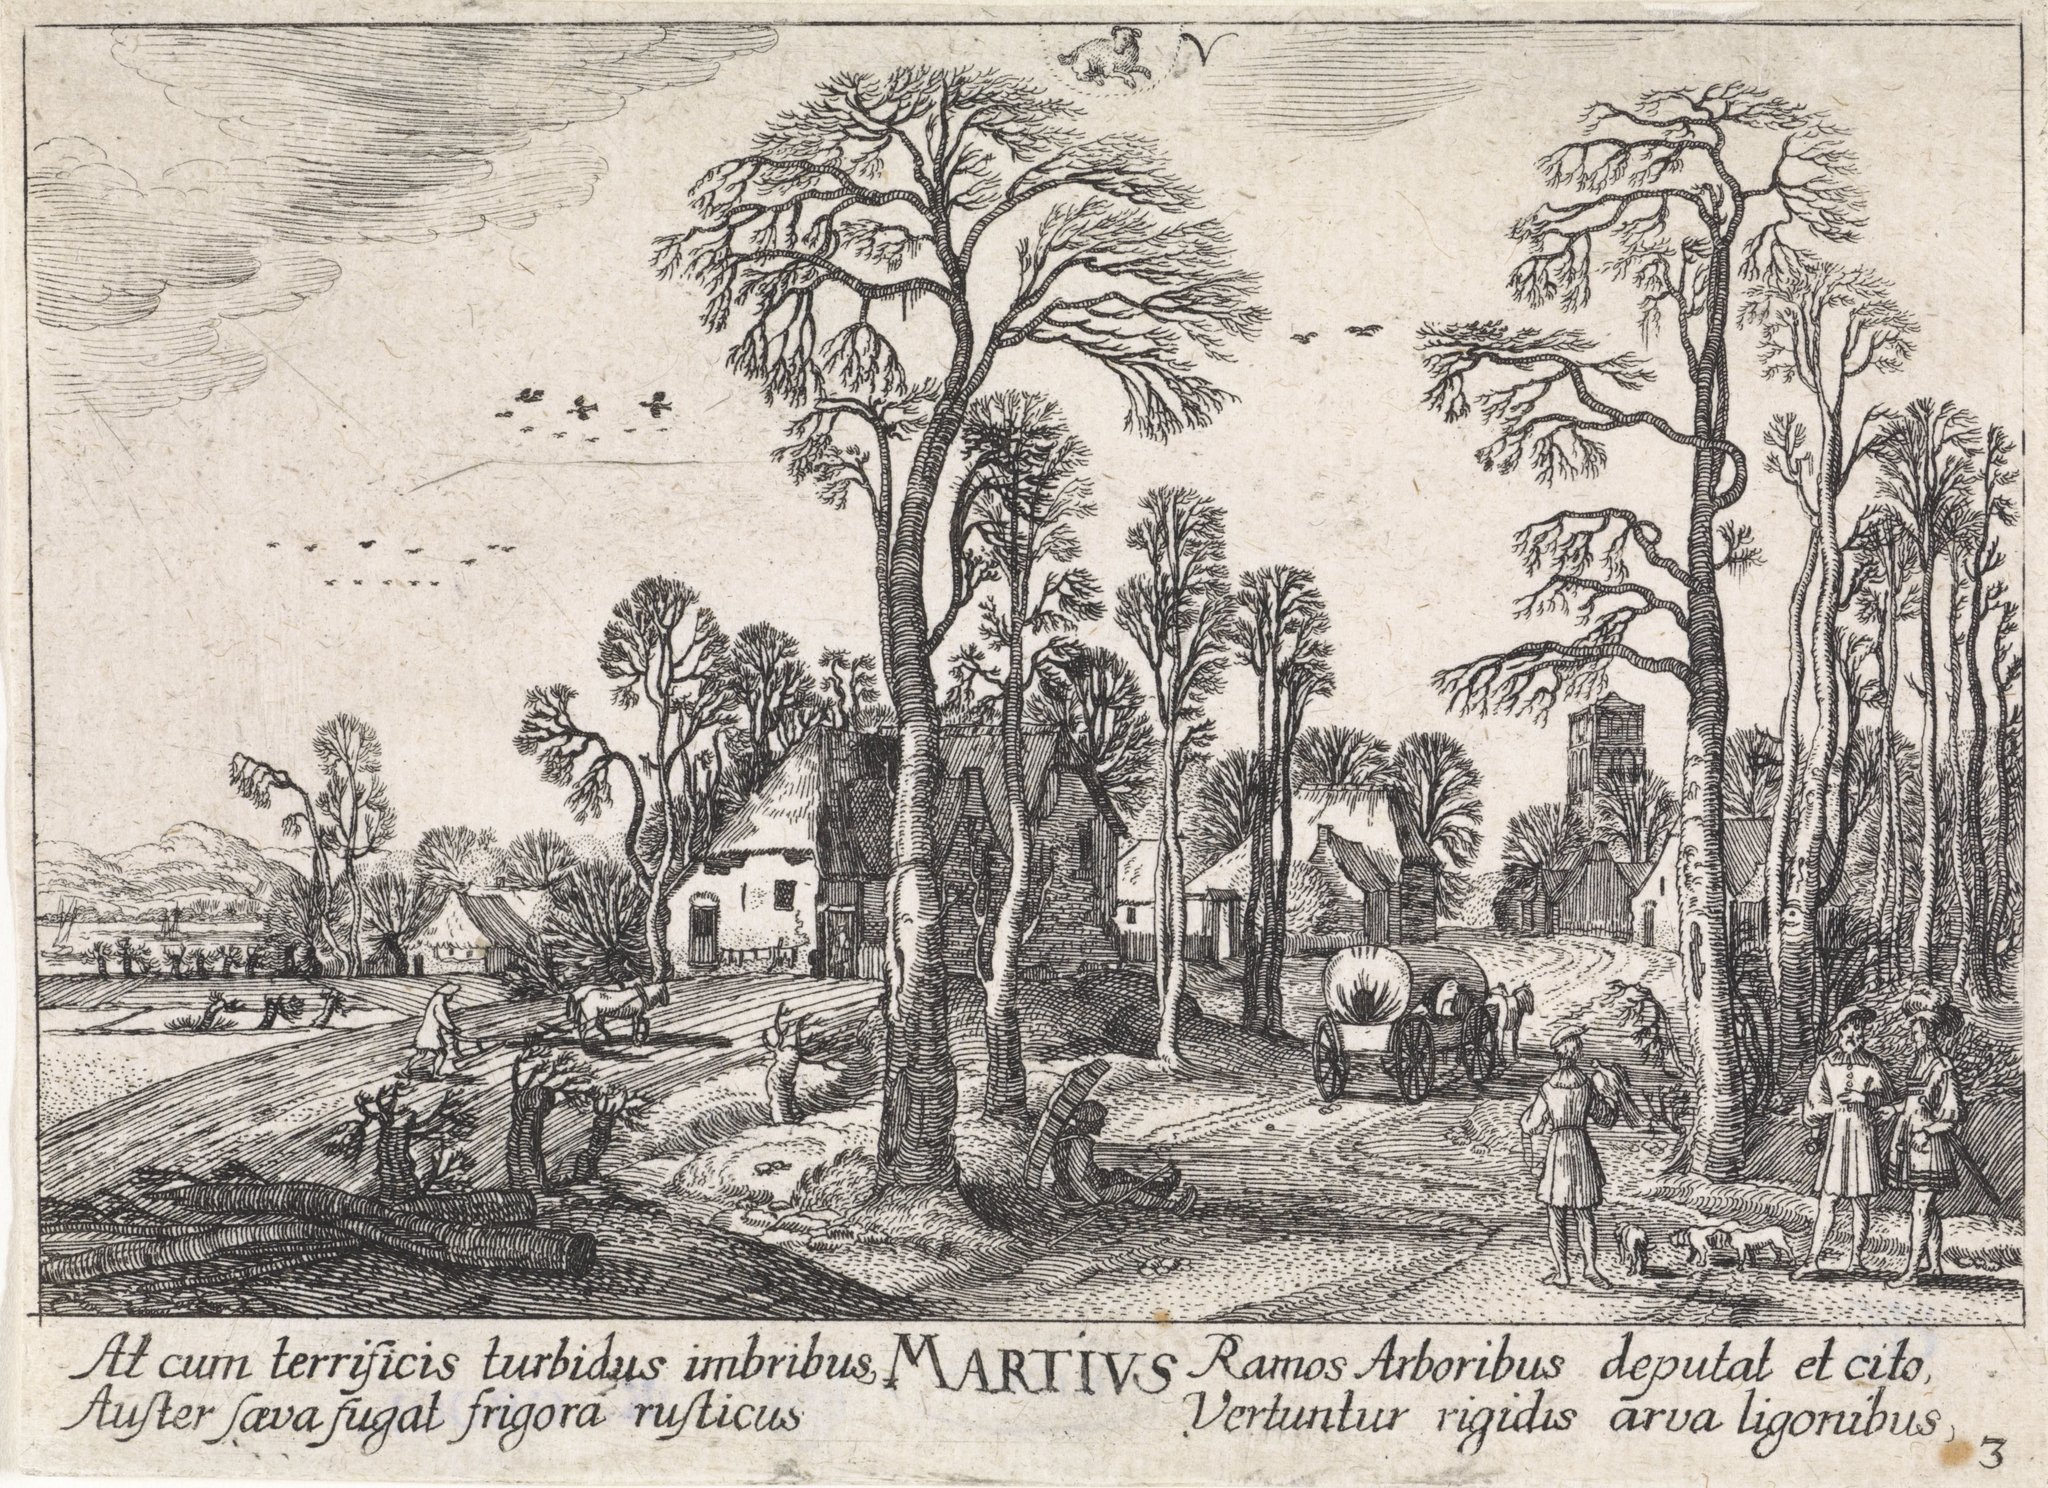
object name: print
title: De twaalf maanden, met dorpsgezichten, kopieën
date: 1684-1729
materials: paper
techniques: etching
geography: germany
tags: landscape symbolizing march, village, aries (zodical sign of march), ploughing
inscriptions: collector's mark: Lugt 2760, collector's mark: Lugt 3790, collector's mark: Lugt 384, collector's mark: Lugt 2228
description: Landschap met een landweg waarop figuren en een huifkar, met op de achtergrond een dorp, voorstellende de weg van Lisse naar Hillegom. Links een ploegende boer. Landschap voorstellende de de maand maart. Bovenaan het bij deze maand behorende sterrenbeeld: ram. Derde prent uit een serie van twaalf.